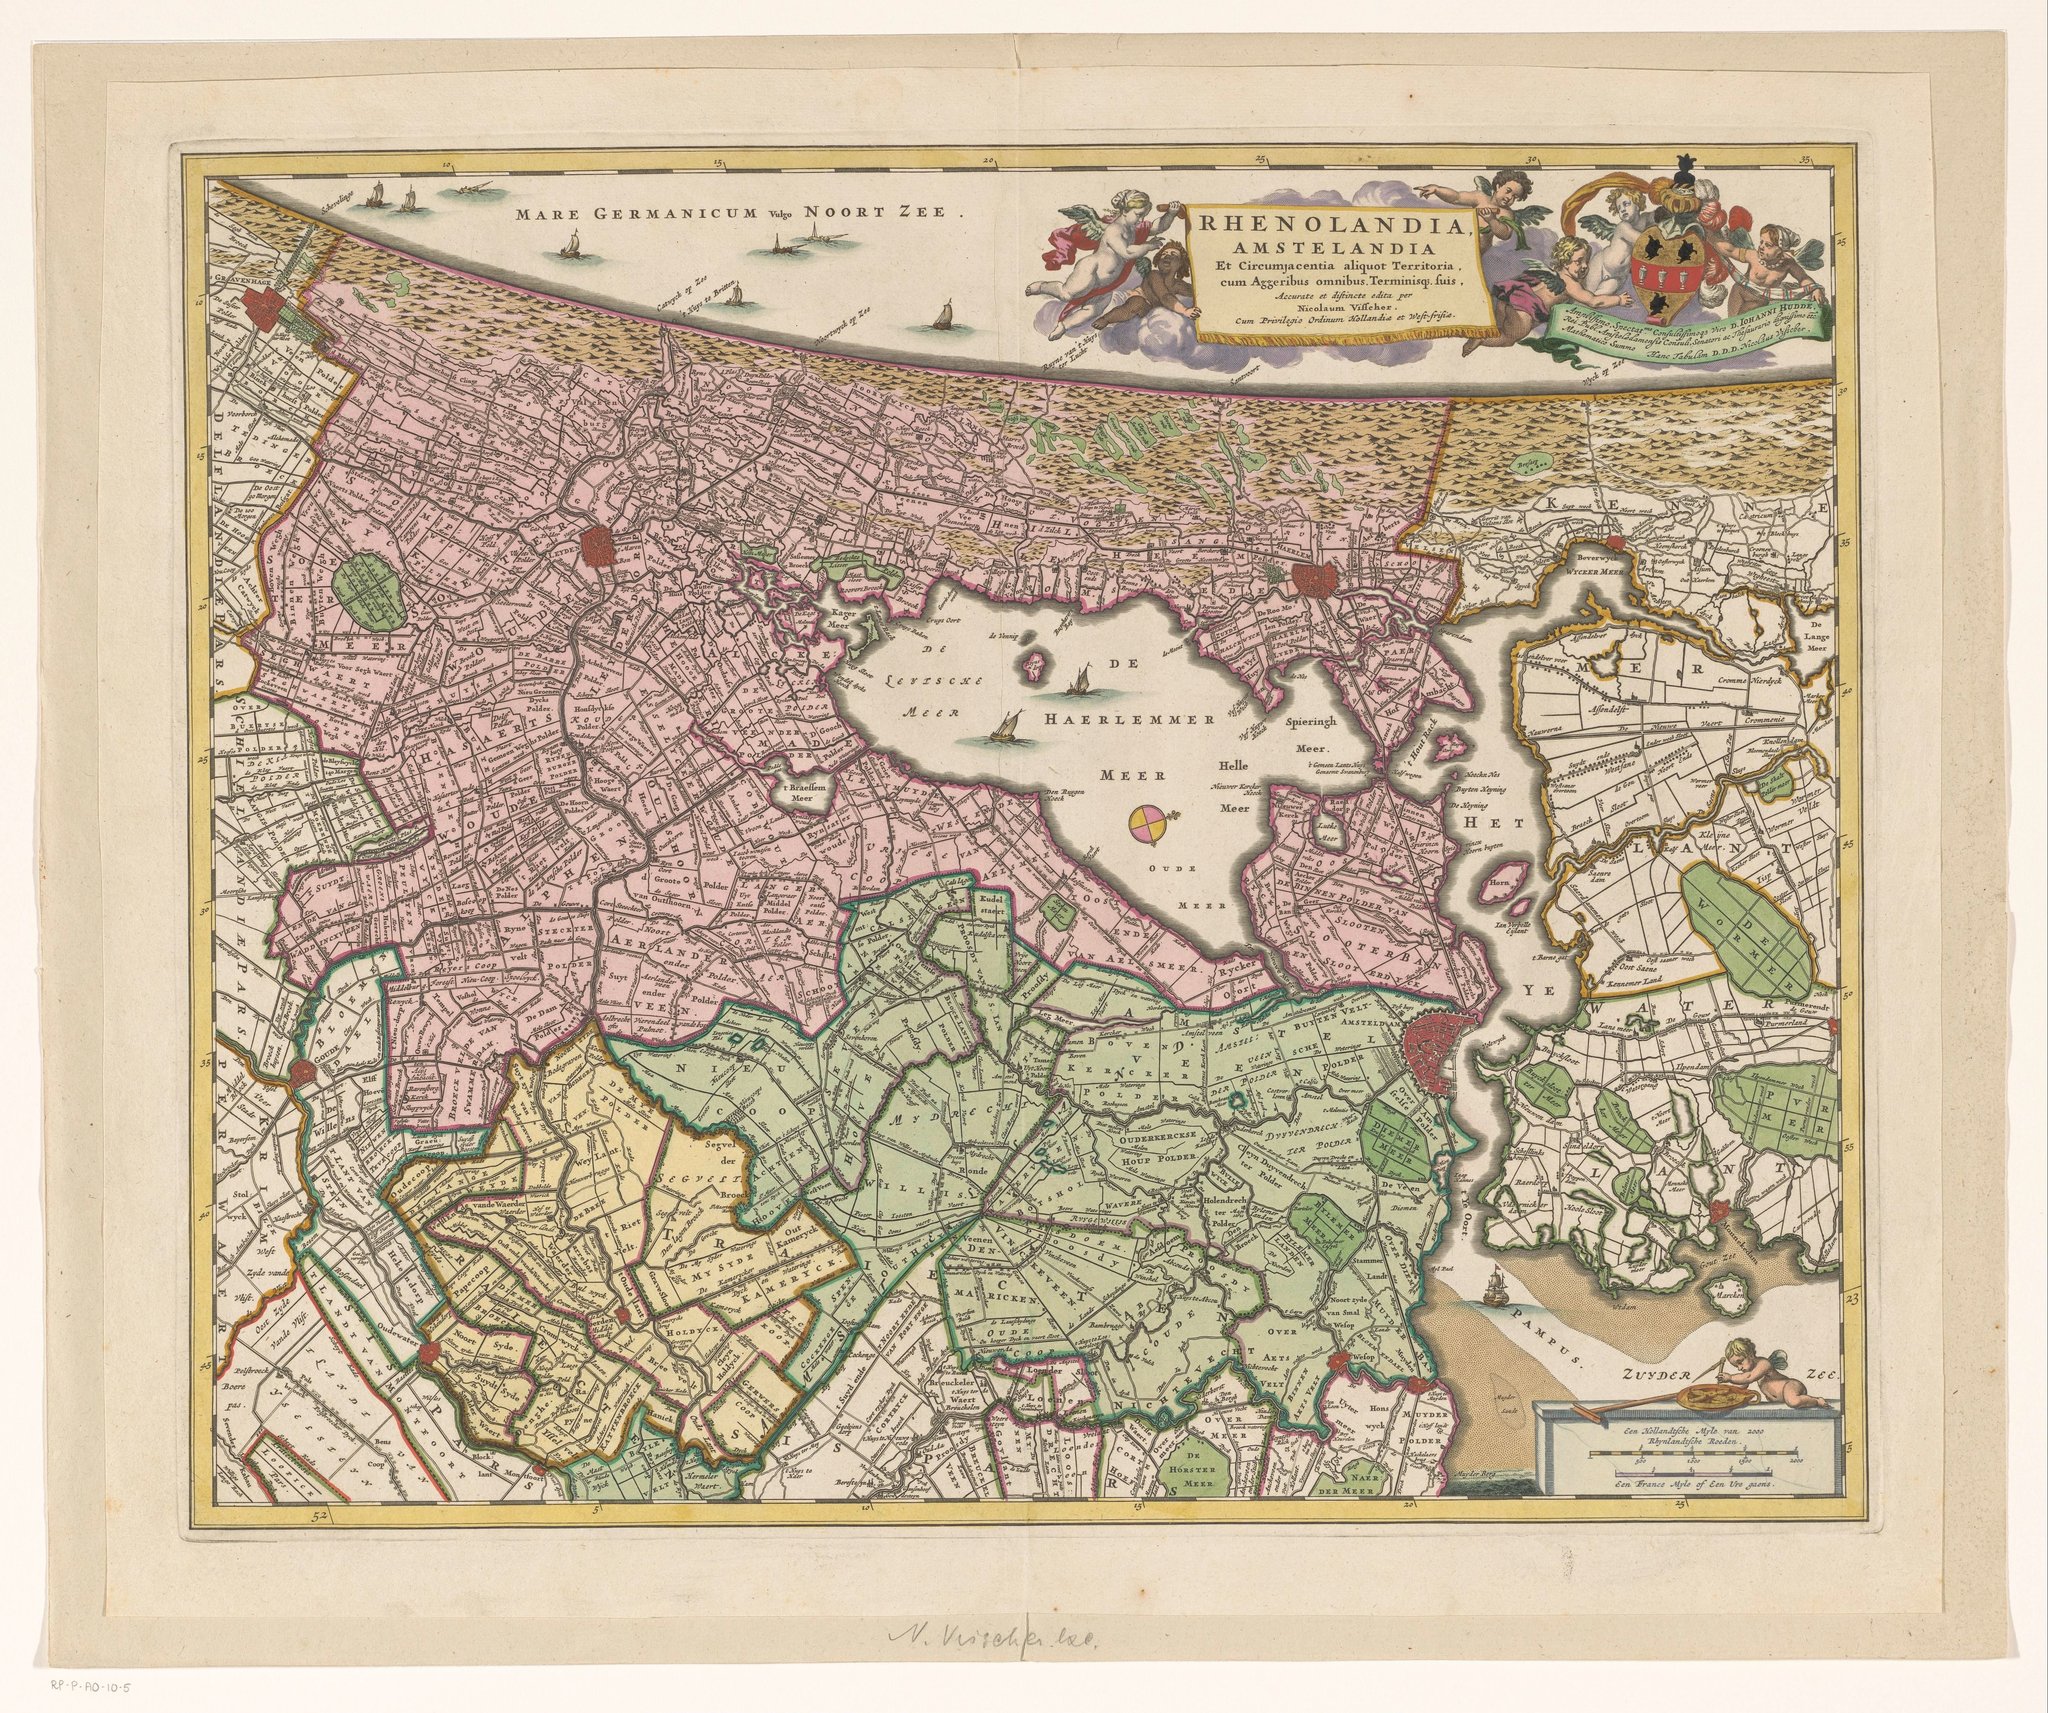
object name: map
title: Kaart van Rijnland en Amstelland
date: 1677-1682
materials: paint, paper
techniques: brush, engraving, etching, hand coloring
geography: amsterdam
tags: maps of separate countries or regions, armorial bearing, heraldry, instruments used in geodesy, surveying instruments, holland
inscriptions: collector's mark: Lugt 2228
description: Kaart van Rijnland en Amstelland, het centrale deel van Holland. Rechtsboven een cartouche met de titel en een cartouche met de opdracht, daarboven het wapen van de Amsterdamse burgemeester Johannes Hudde. Rechtsonder twee schaalstokken: Een Hollandtsche myle van 200 Rhynlandtsche roeden; Een France myle of een ure gaens. Daarboven een putto met meetapparatuur. Gradenverdeling langs de randen. Oriëntatie: noorden rechts.